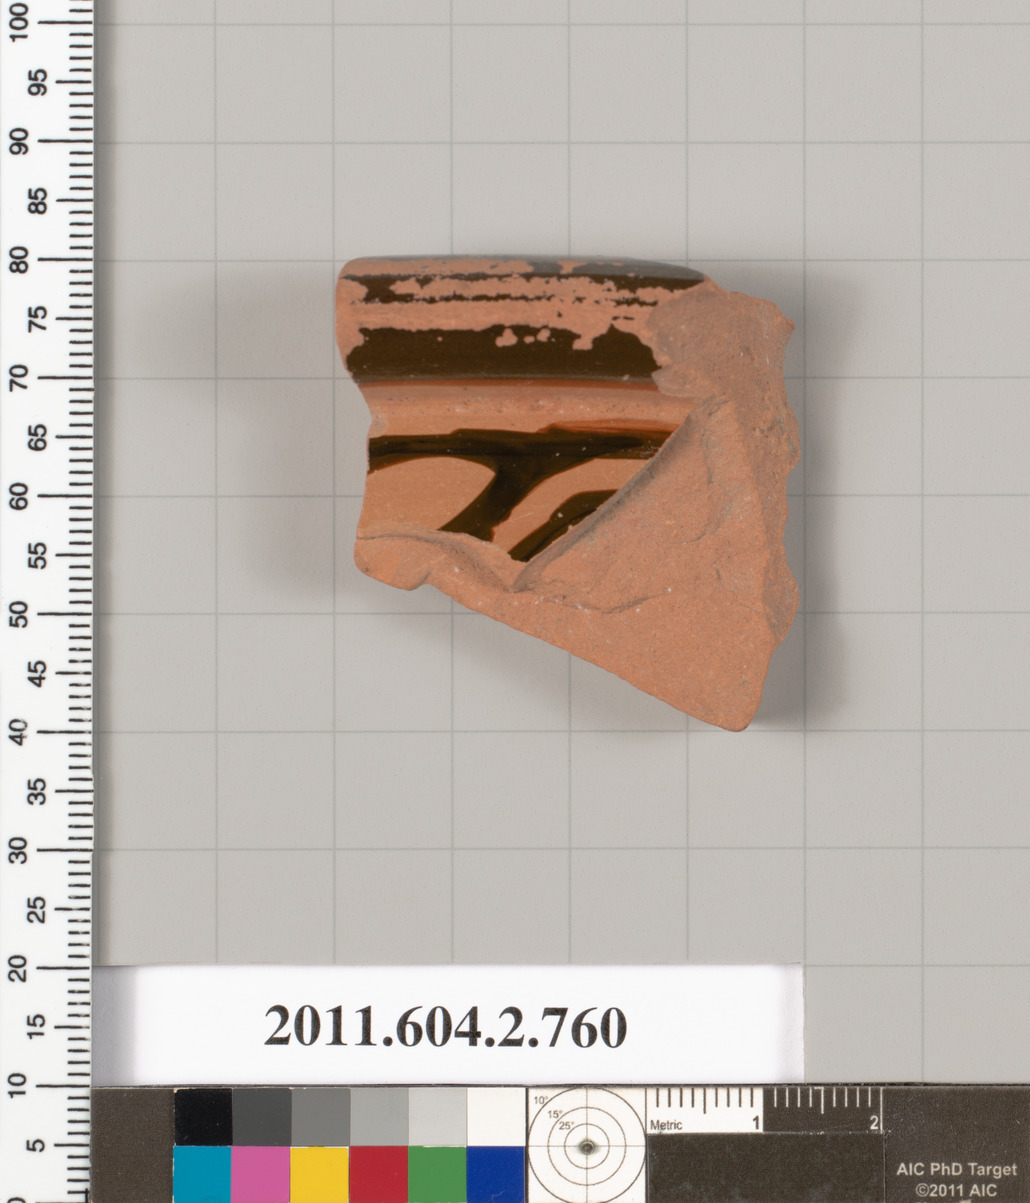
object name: calyx krater fragment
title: Terracotta fragment of a calyx-krater (bowl for mixing wine and water)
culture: greek, attic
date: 500-451 BCE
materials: terracotta